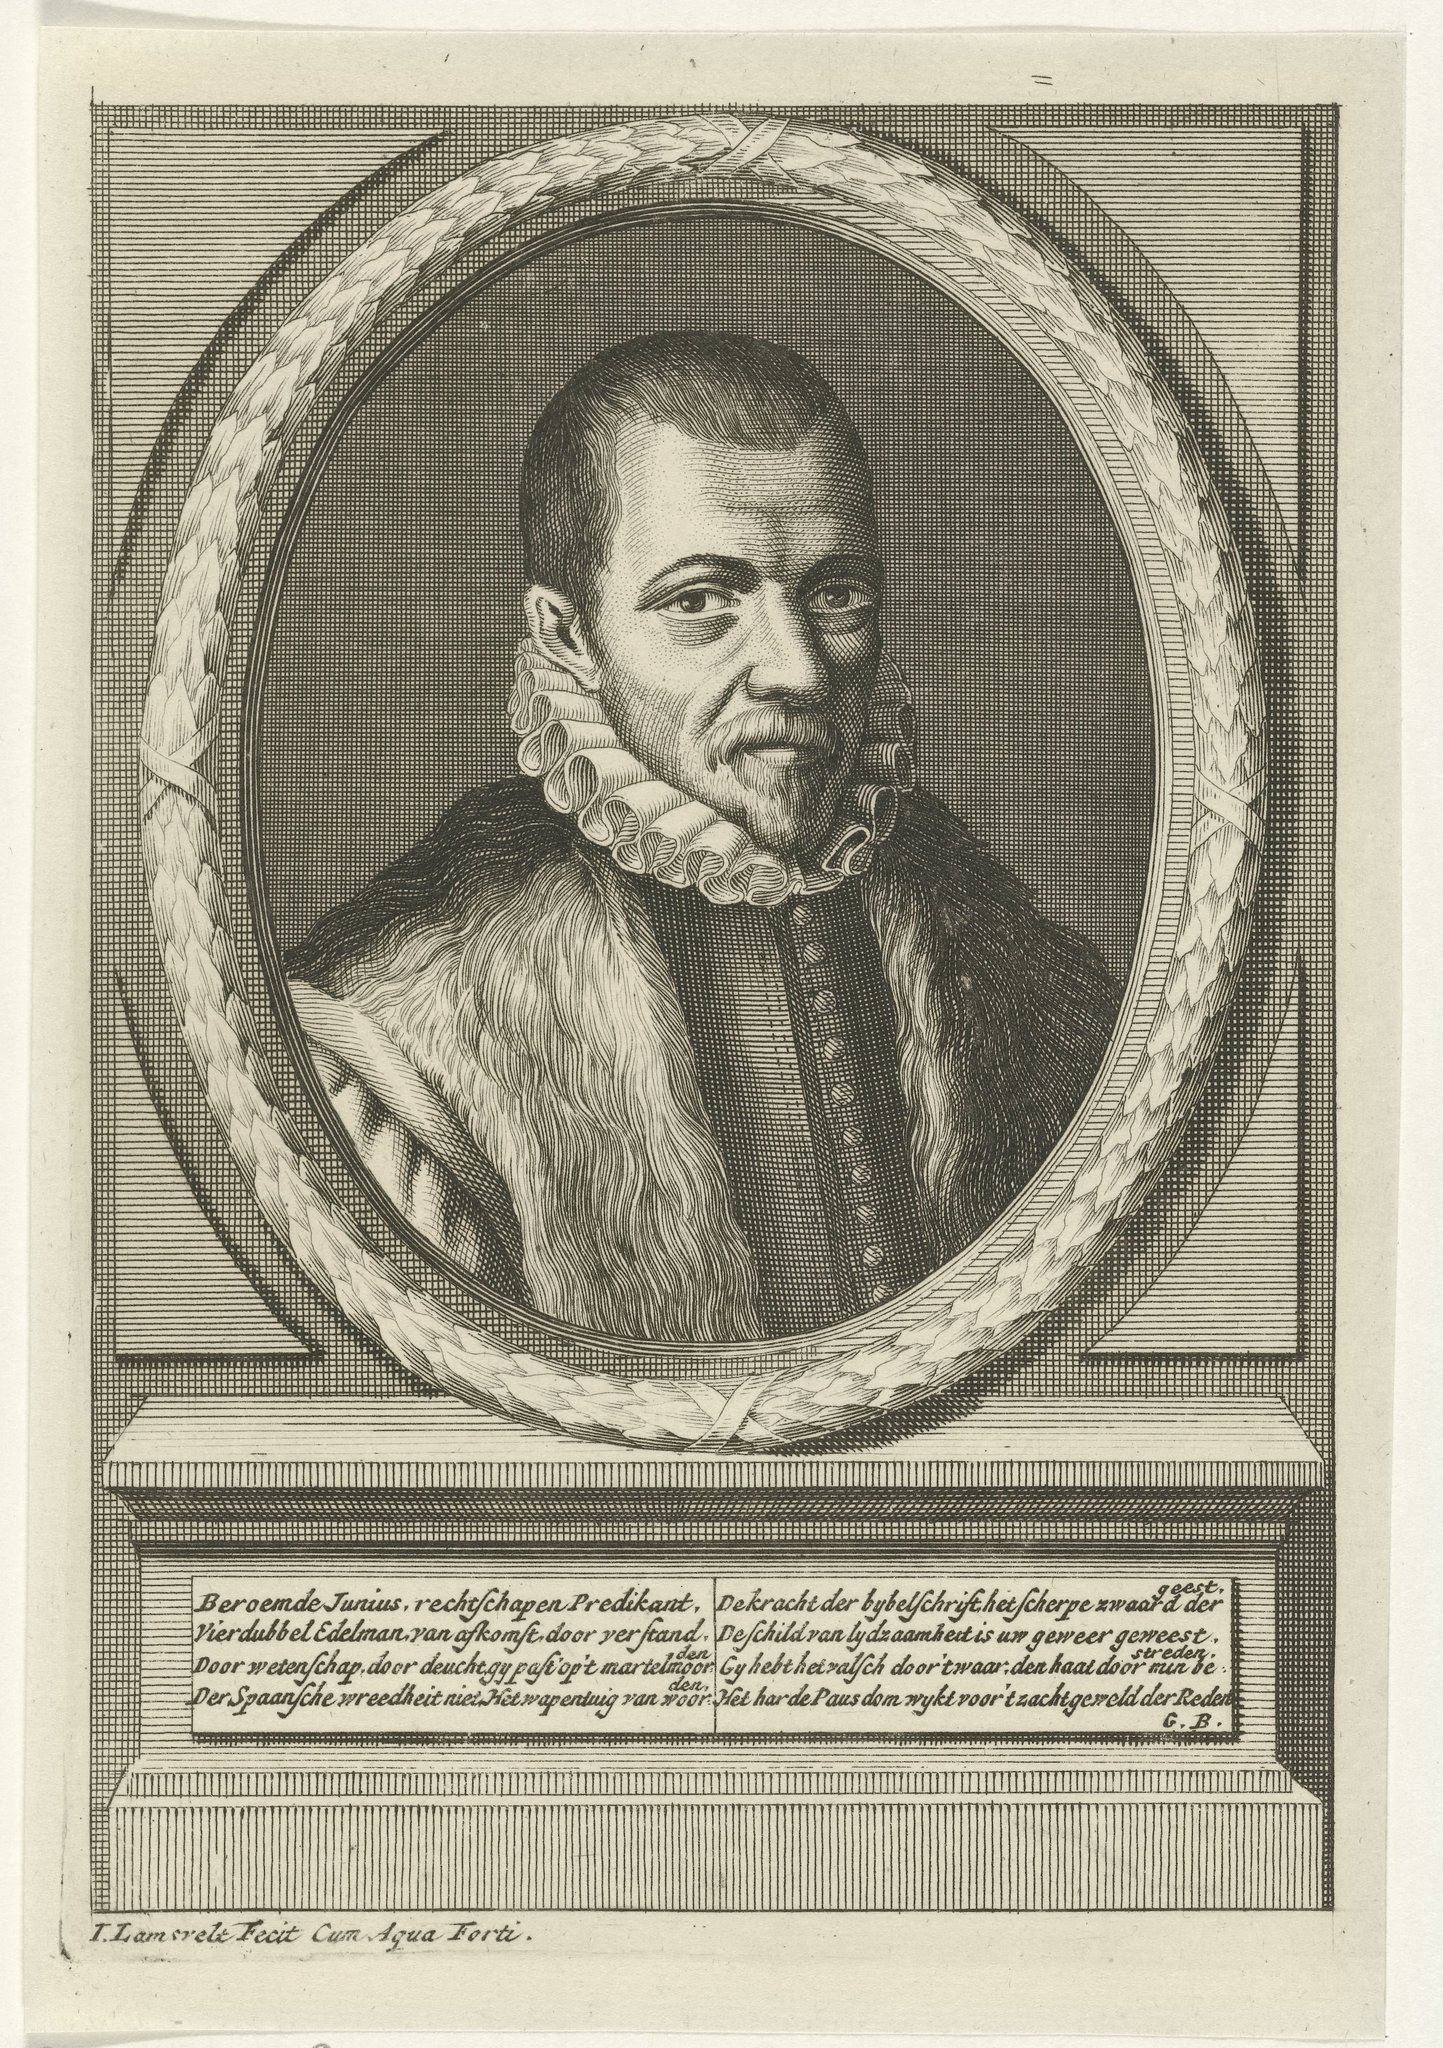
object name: print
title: Portret van Franciscus Junius I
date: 1696-1743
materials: paper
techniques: engraving, etching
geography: amsterdam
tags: leiden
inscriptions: collector's mark: Lugt 2228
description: Prent ook gebruikt in: G. Brandts Historie der Reformatie, en andre kerkelyke geschiedenissen, in en ontrent de Nederlanden. Met eenige aantekeningen en aenmerkingen, Naerder oversien, merkelijk vermeerdert, en vervolgt tot het jaer 1600 [Het eerste deel]. 2e druk [moet een latere druk zijn]. Amsterdam: Jan Rieuwertsz. en Hendrik en Dirk Boom [?], 1677 [in of na 1696], tussen p. 788 en 789.* *Hoewel op de titelpagina deze uitgevers worden genoemd en het jaartal 1677 staat vermeld als jaar van uitgave, kan dit niet kloppen. Deze uitgave heeft weliswaar tevens exact dezelfde titel als de werkelijke tweede druk uit 1677, maar is typografisch anders en bevat andere prenten. Alle prenten zijn van de hand van Jan Lamsvelt (werkzame periode: 1696-1743), waardoor het geheel in of na 1696 te dateren valt.